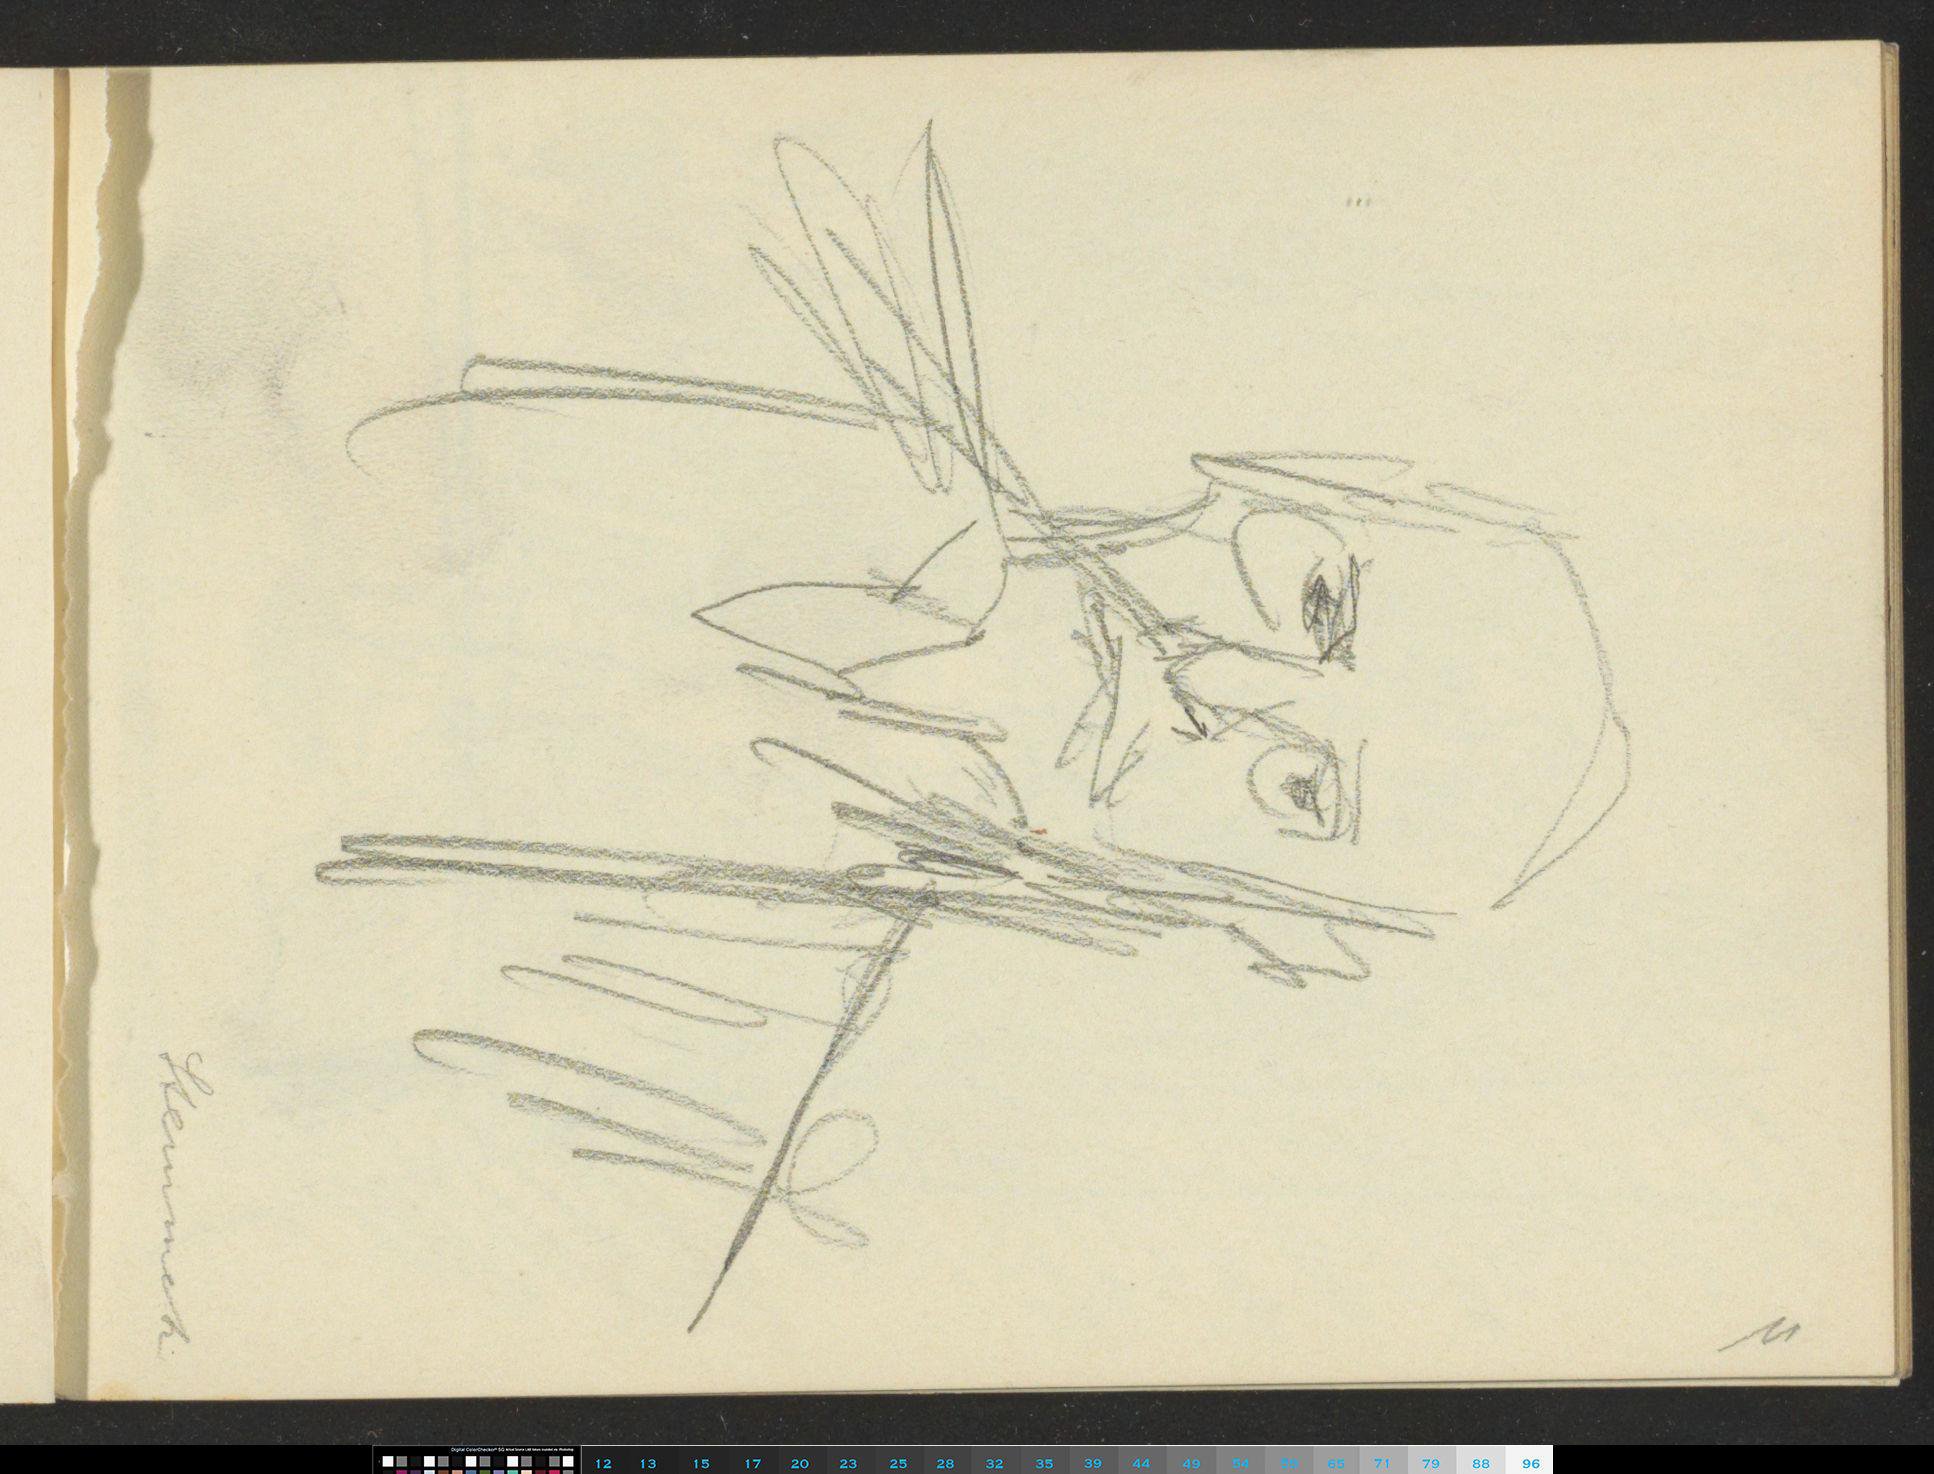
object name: sketchbook leaf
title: Portret van Sebald Rudolf Steinmetz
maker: isaac israels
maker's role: draughtsman, painter, print maker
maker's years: 1865-1934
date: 1875-1934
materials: paper, pencil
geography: the hague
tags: historical persons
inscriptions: annotation: ‘Steinmetz’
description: Blad 11 recto uit schetsboek LVII met 29 bladen.